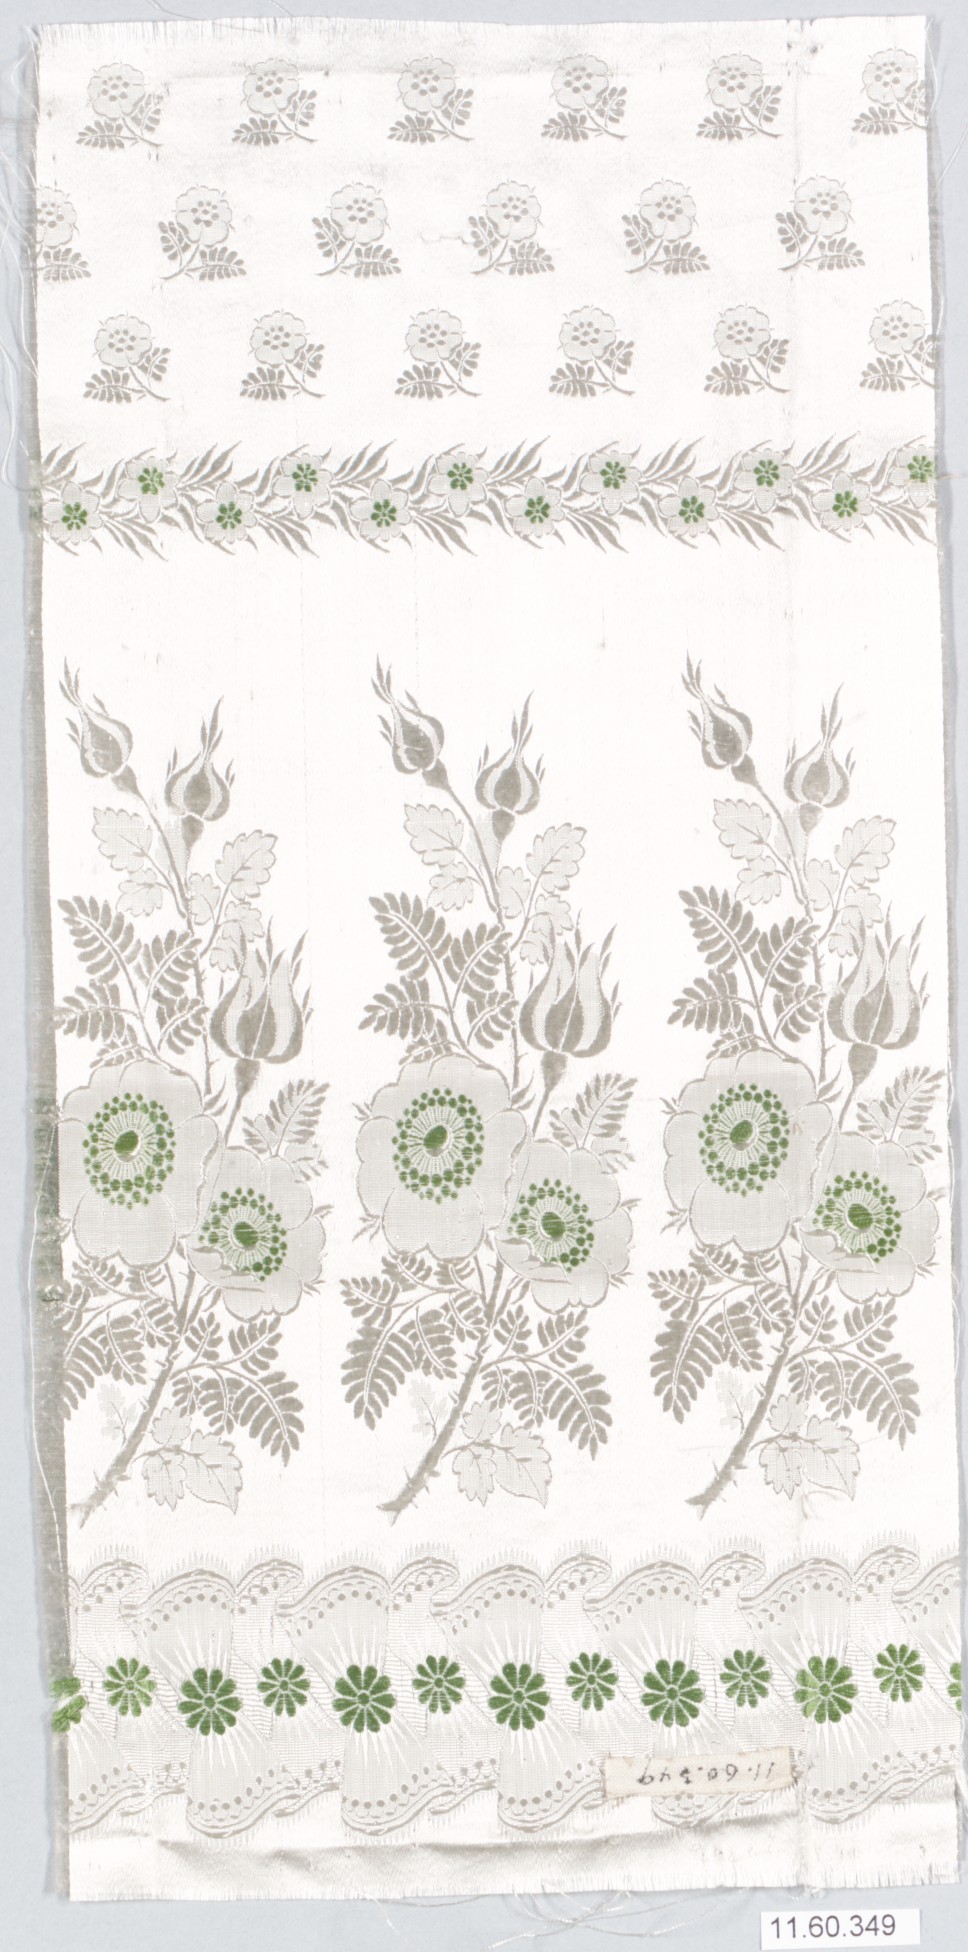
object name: fragment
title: Fragments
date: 1801-1900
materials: silk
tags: flowers,leaves